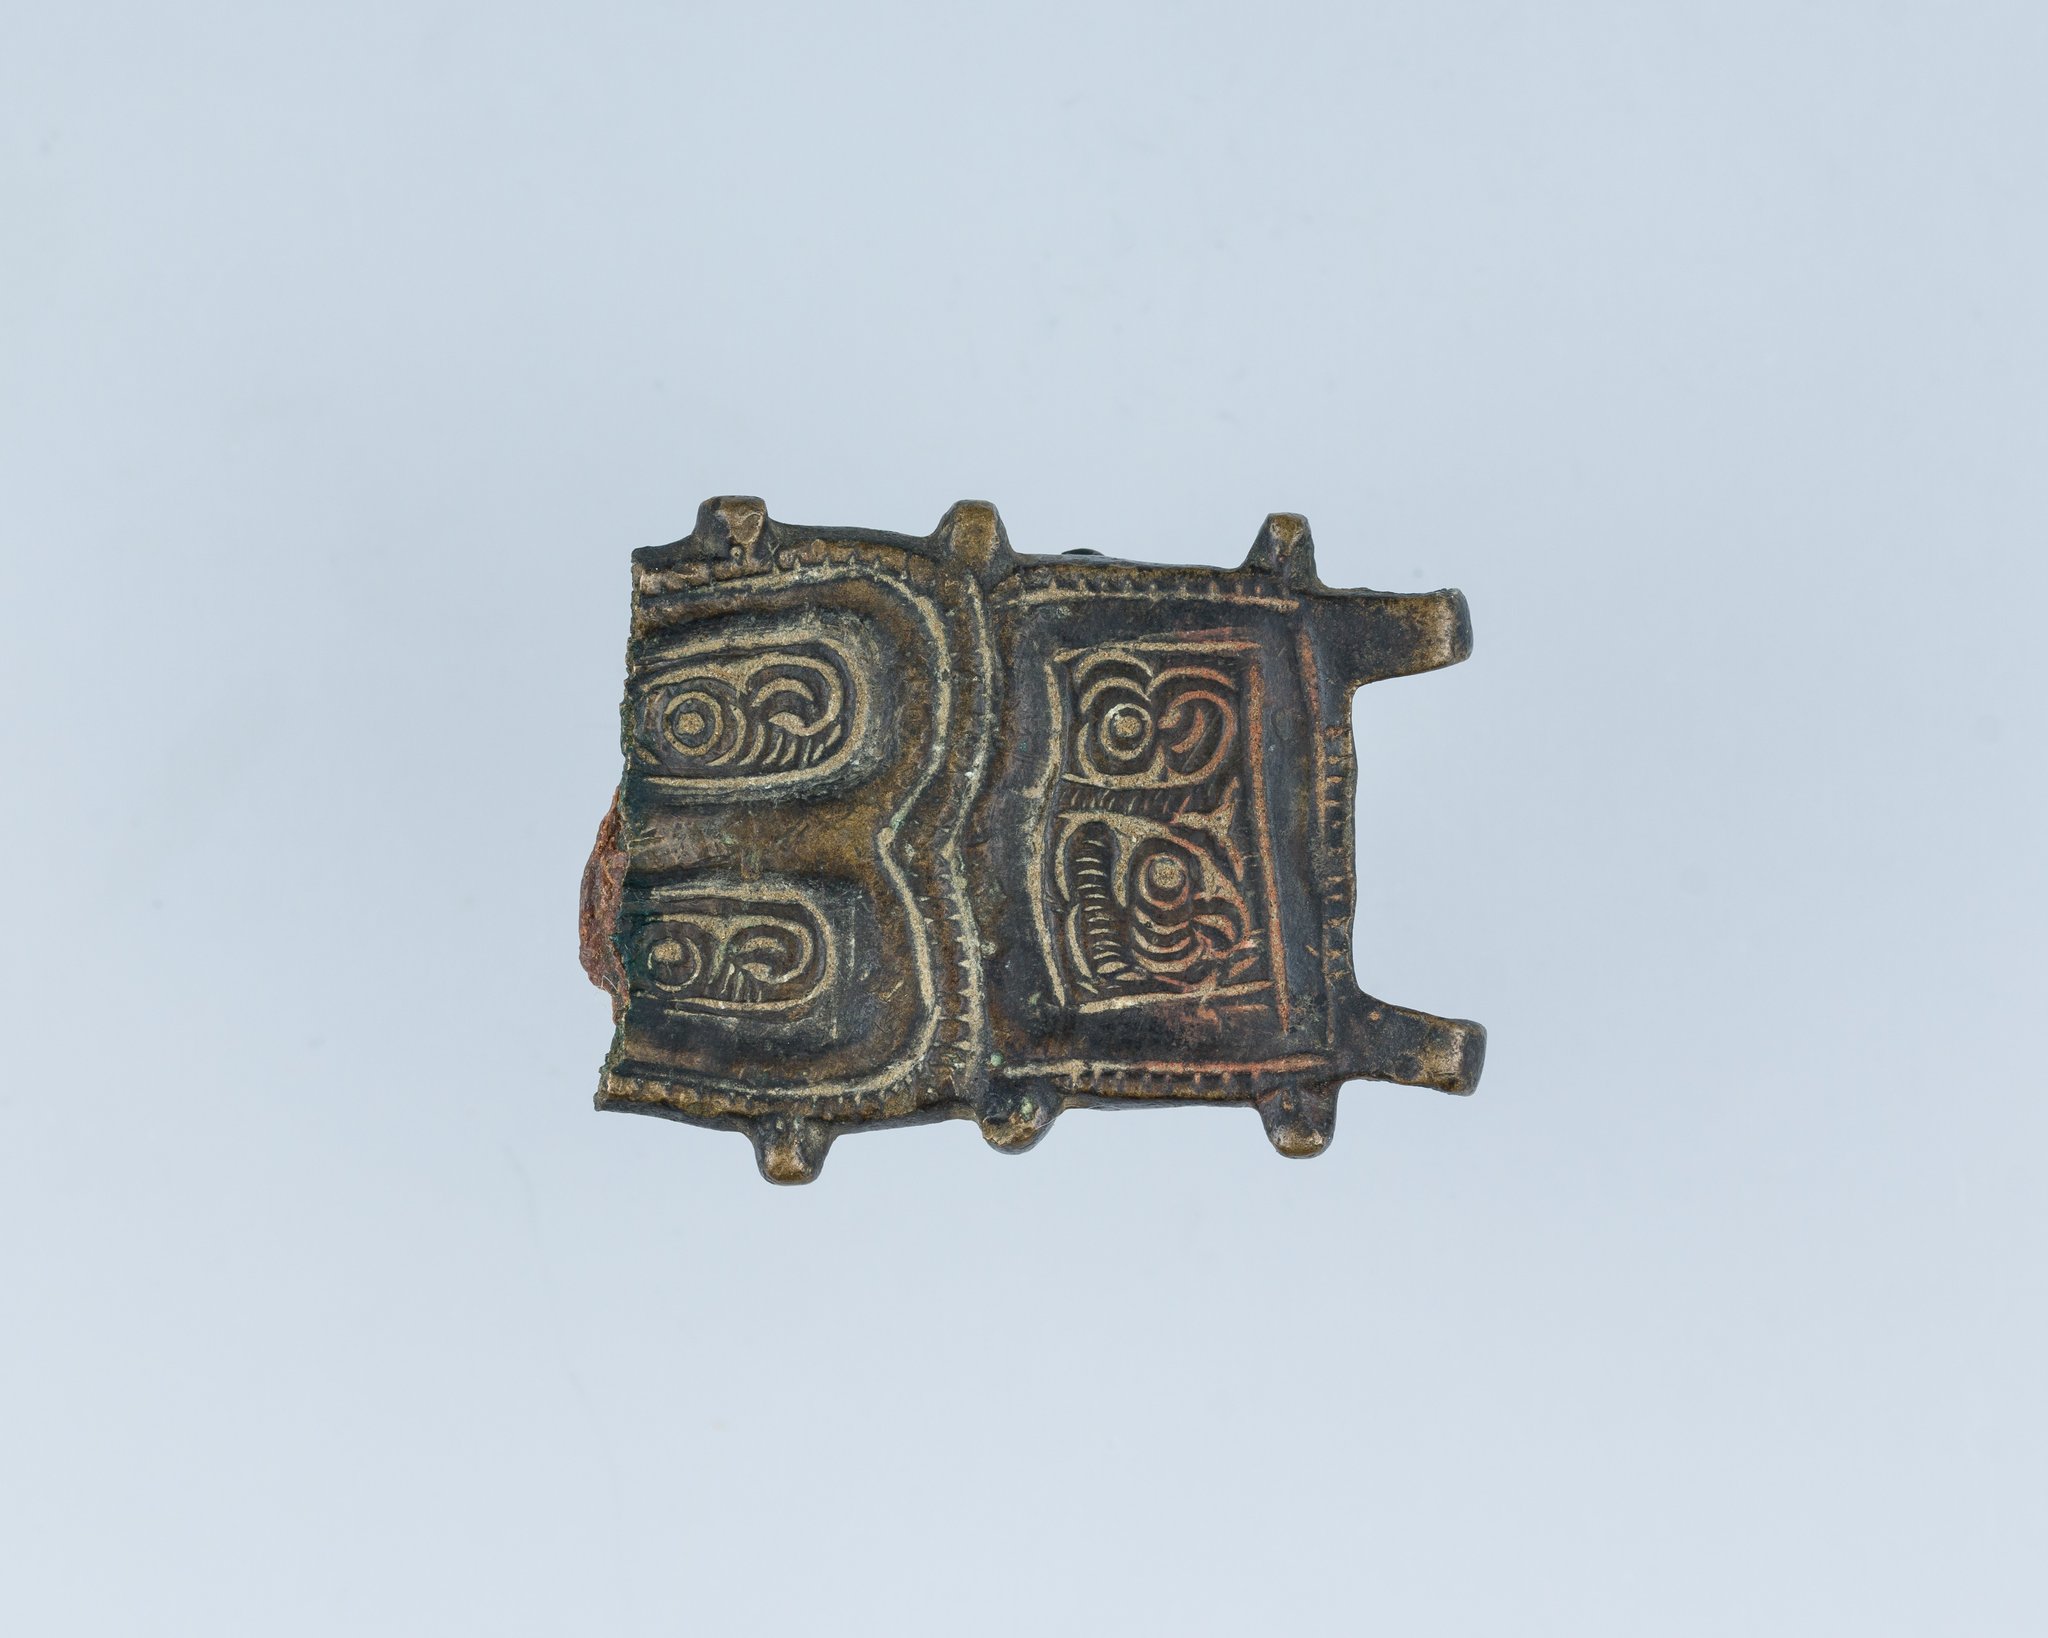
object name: buckle shank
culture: visigothic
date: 401-700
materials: bronze